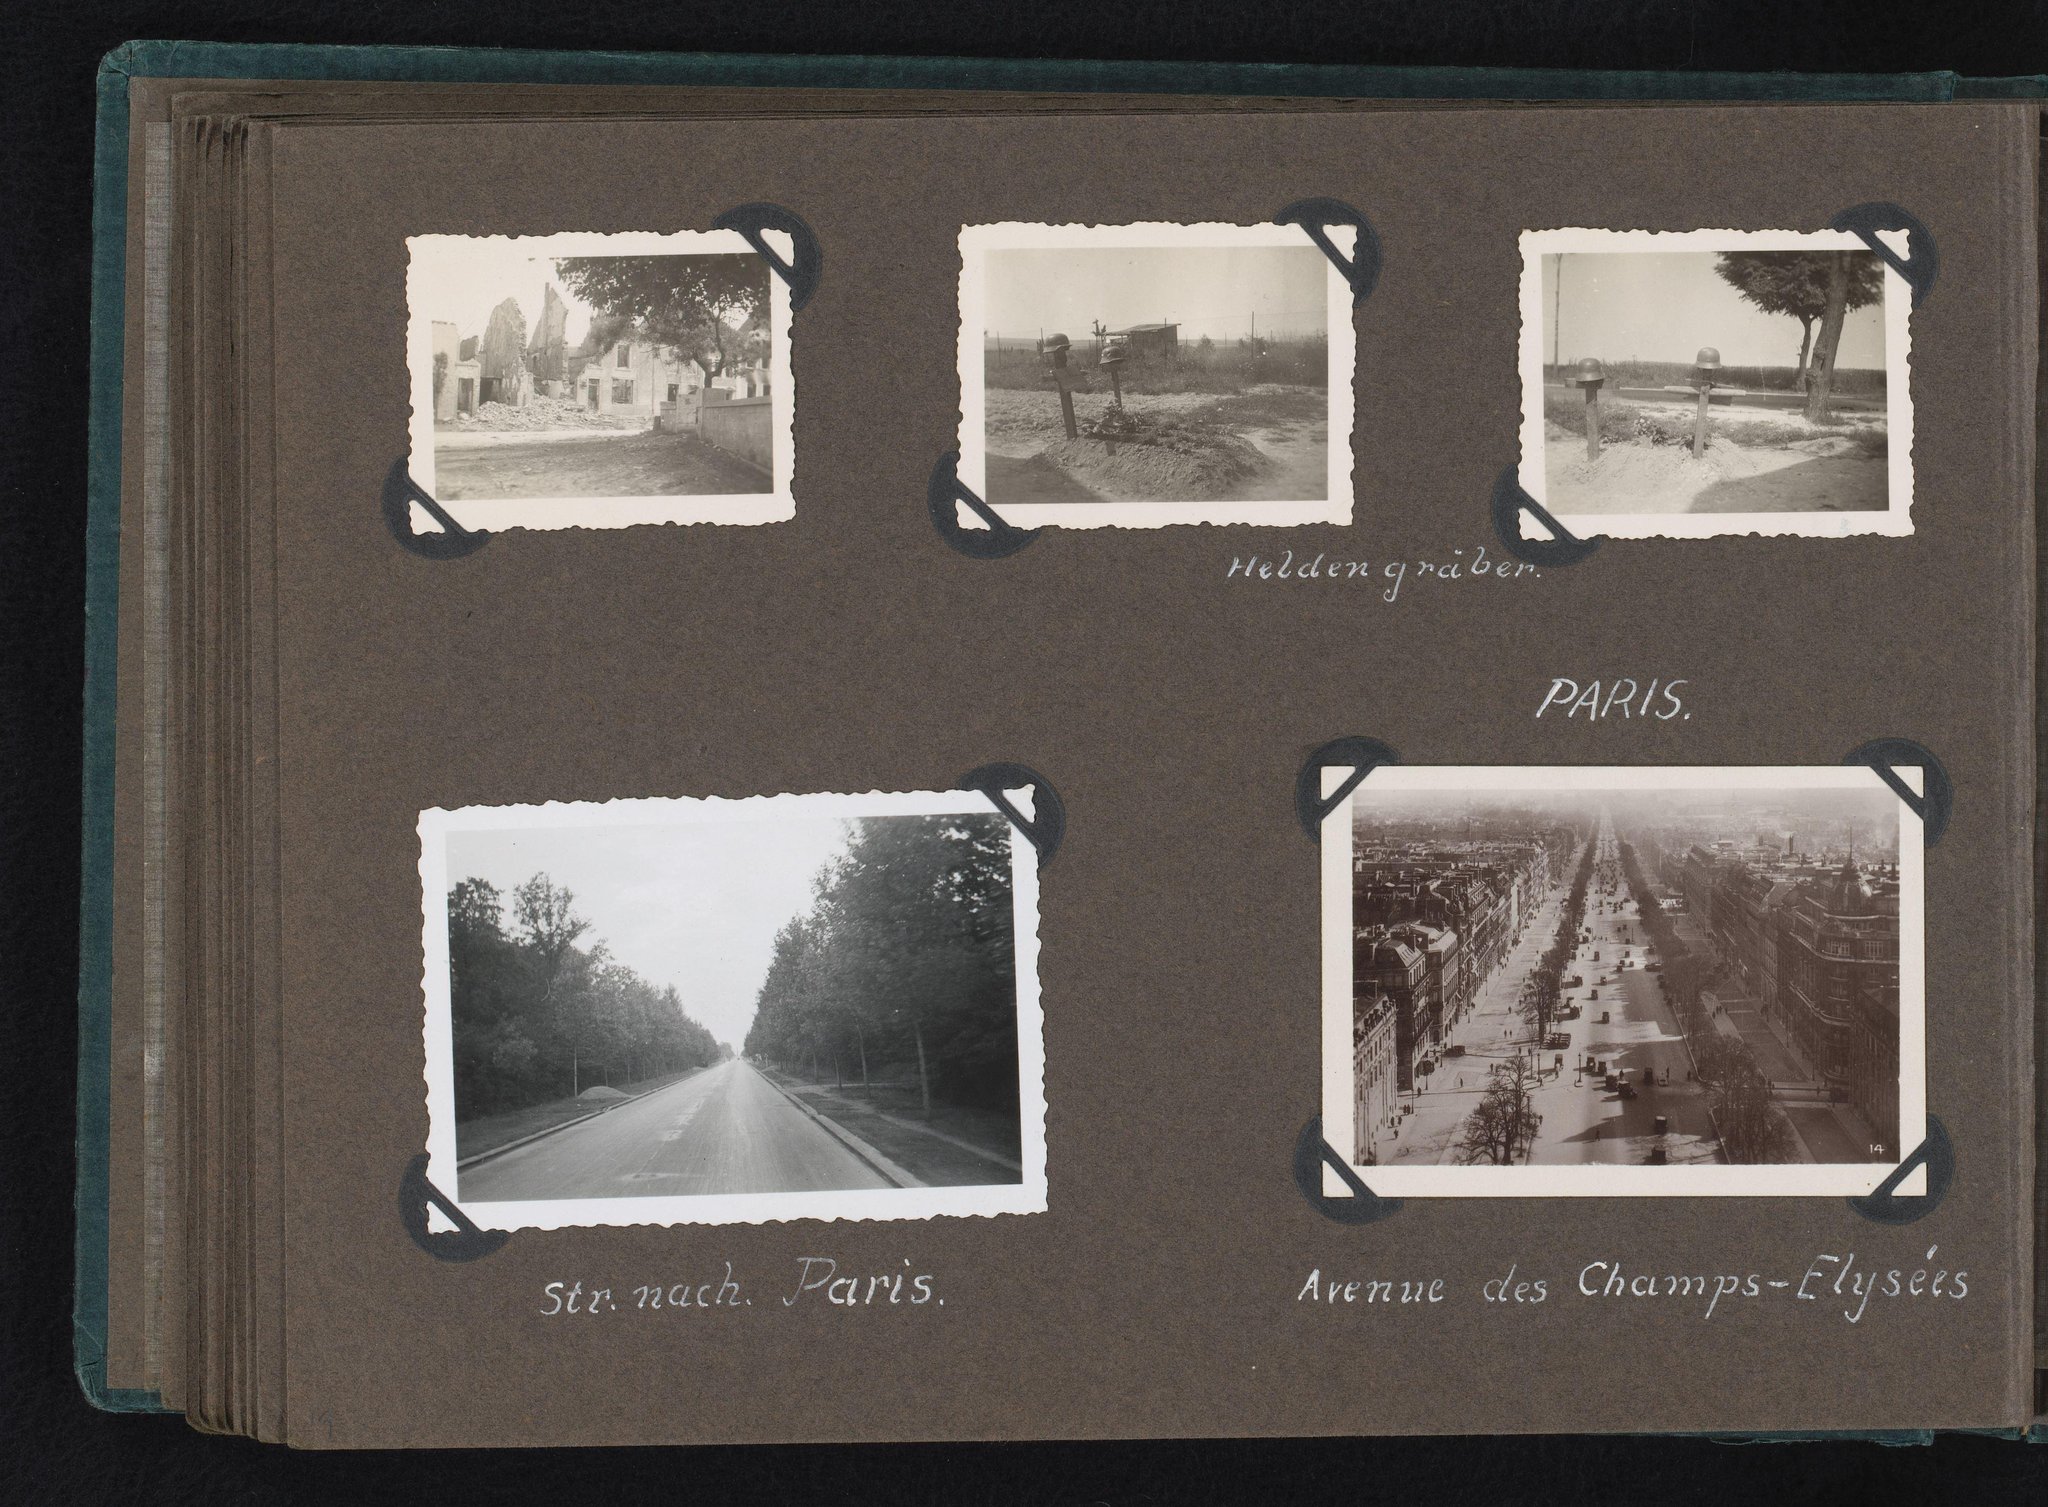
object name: photograph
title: Oorlogsgraven en Parijs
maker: Anonymous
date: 1940-1945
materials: cardboard, photographic support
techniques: gelatin silver print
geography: france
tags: troop movements, transportation, grave, tomb, devastated, ruined place or city (~ warfare), france, paris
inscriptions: inscription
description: Albumblad met vijf foto's van Duitse oorlogsgraven en de straten van Parijs. Onderdeel van het fotoalbum 'Kriegserinnerungen' 1940-1945.